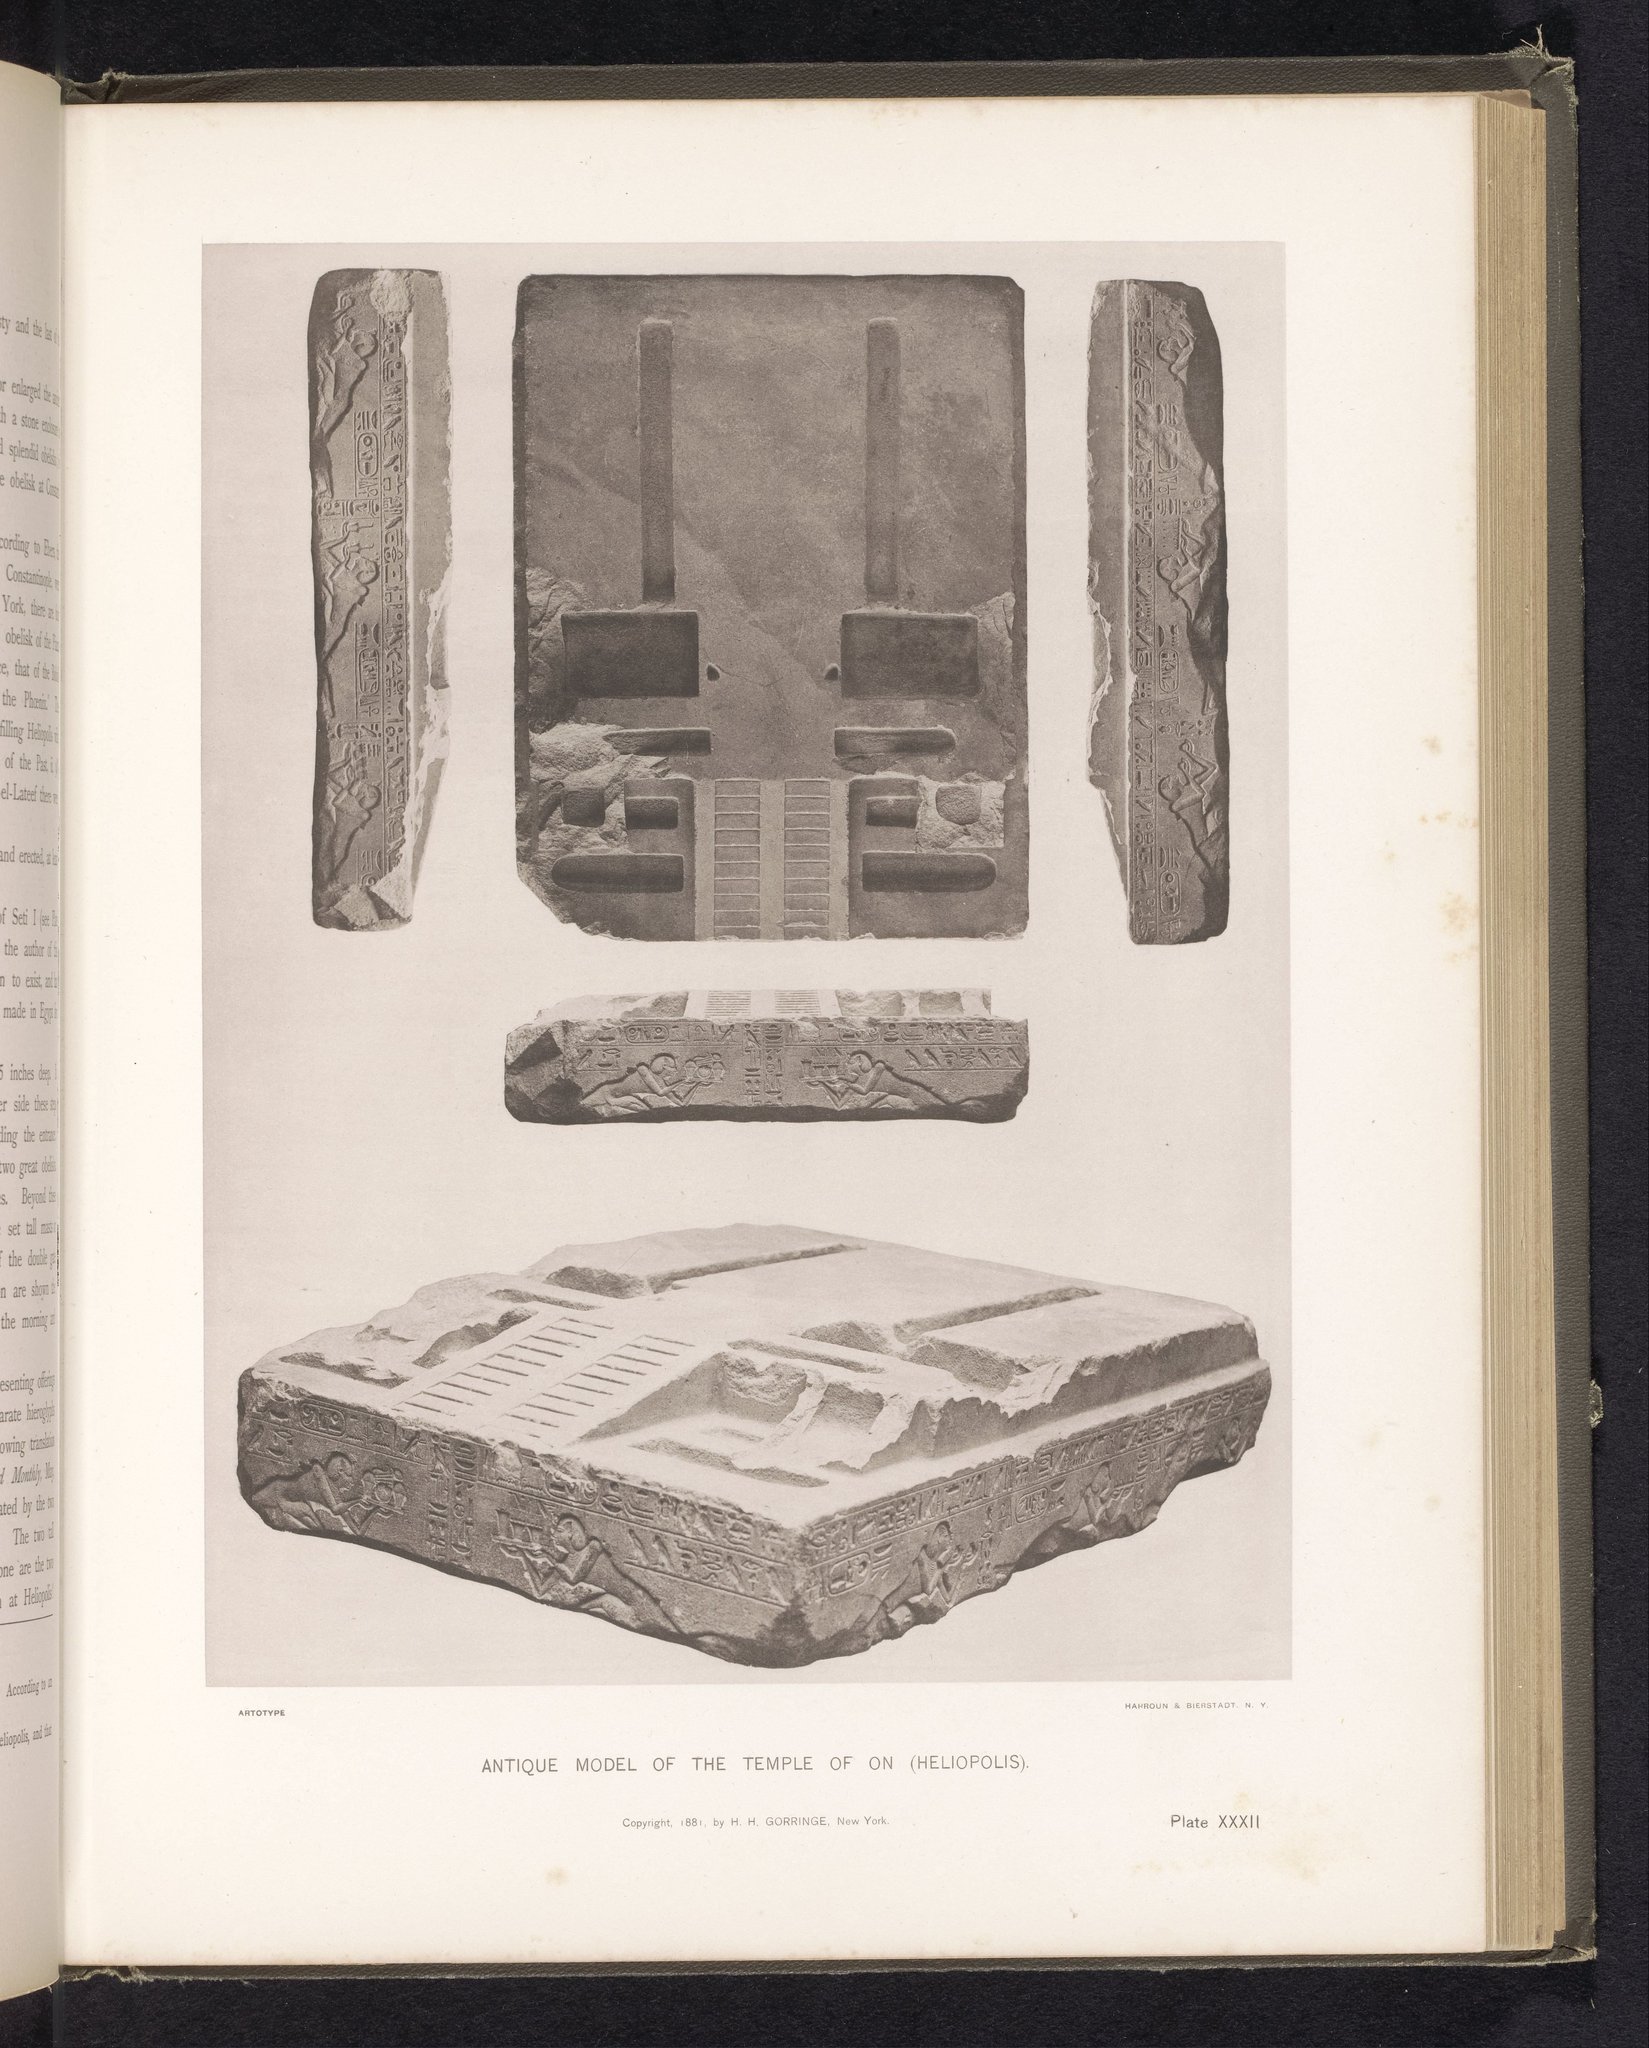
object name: page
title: Antique model of the temple of On (Heliopolis)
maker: Anonymous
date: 1881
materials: paper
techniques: photograph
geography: new york city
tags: temple, shrine ~ egyptian religion, model ~ architecture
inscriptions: inscription: ‘Plate XXXII’, inscription: ‘Copyright, 1881, by H.H. Gorringe, New York’